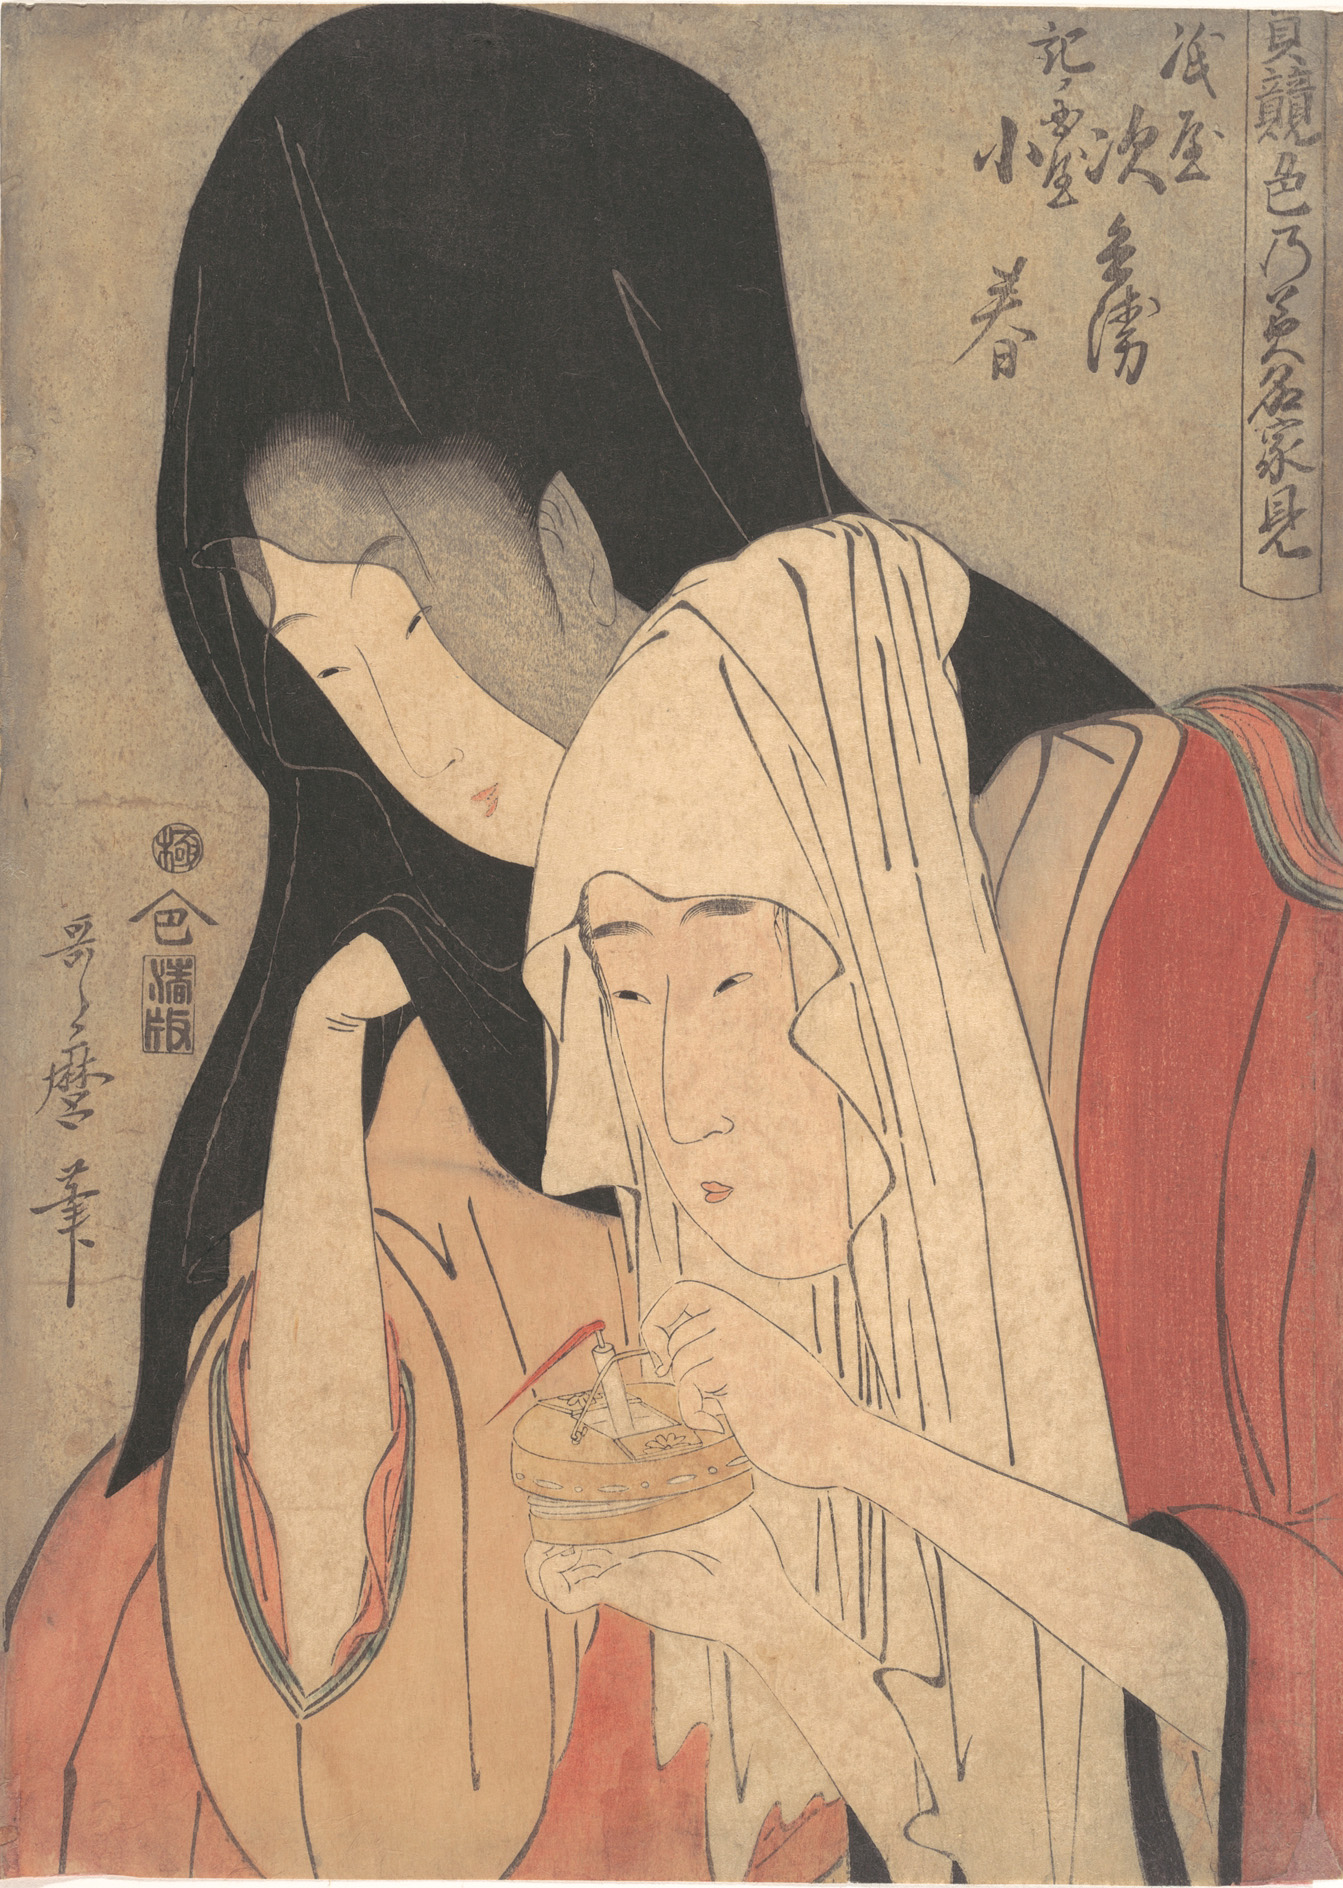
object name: print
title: Jihei of Kamiya Eloping with Koharu of Kinokuniya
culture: japanese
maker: kitagawa utamaro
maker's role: artist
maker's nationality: japanese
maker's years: 1754-1806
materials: ink, paper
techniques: woodblock print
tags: men,women,lanterns